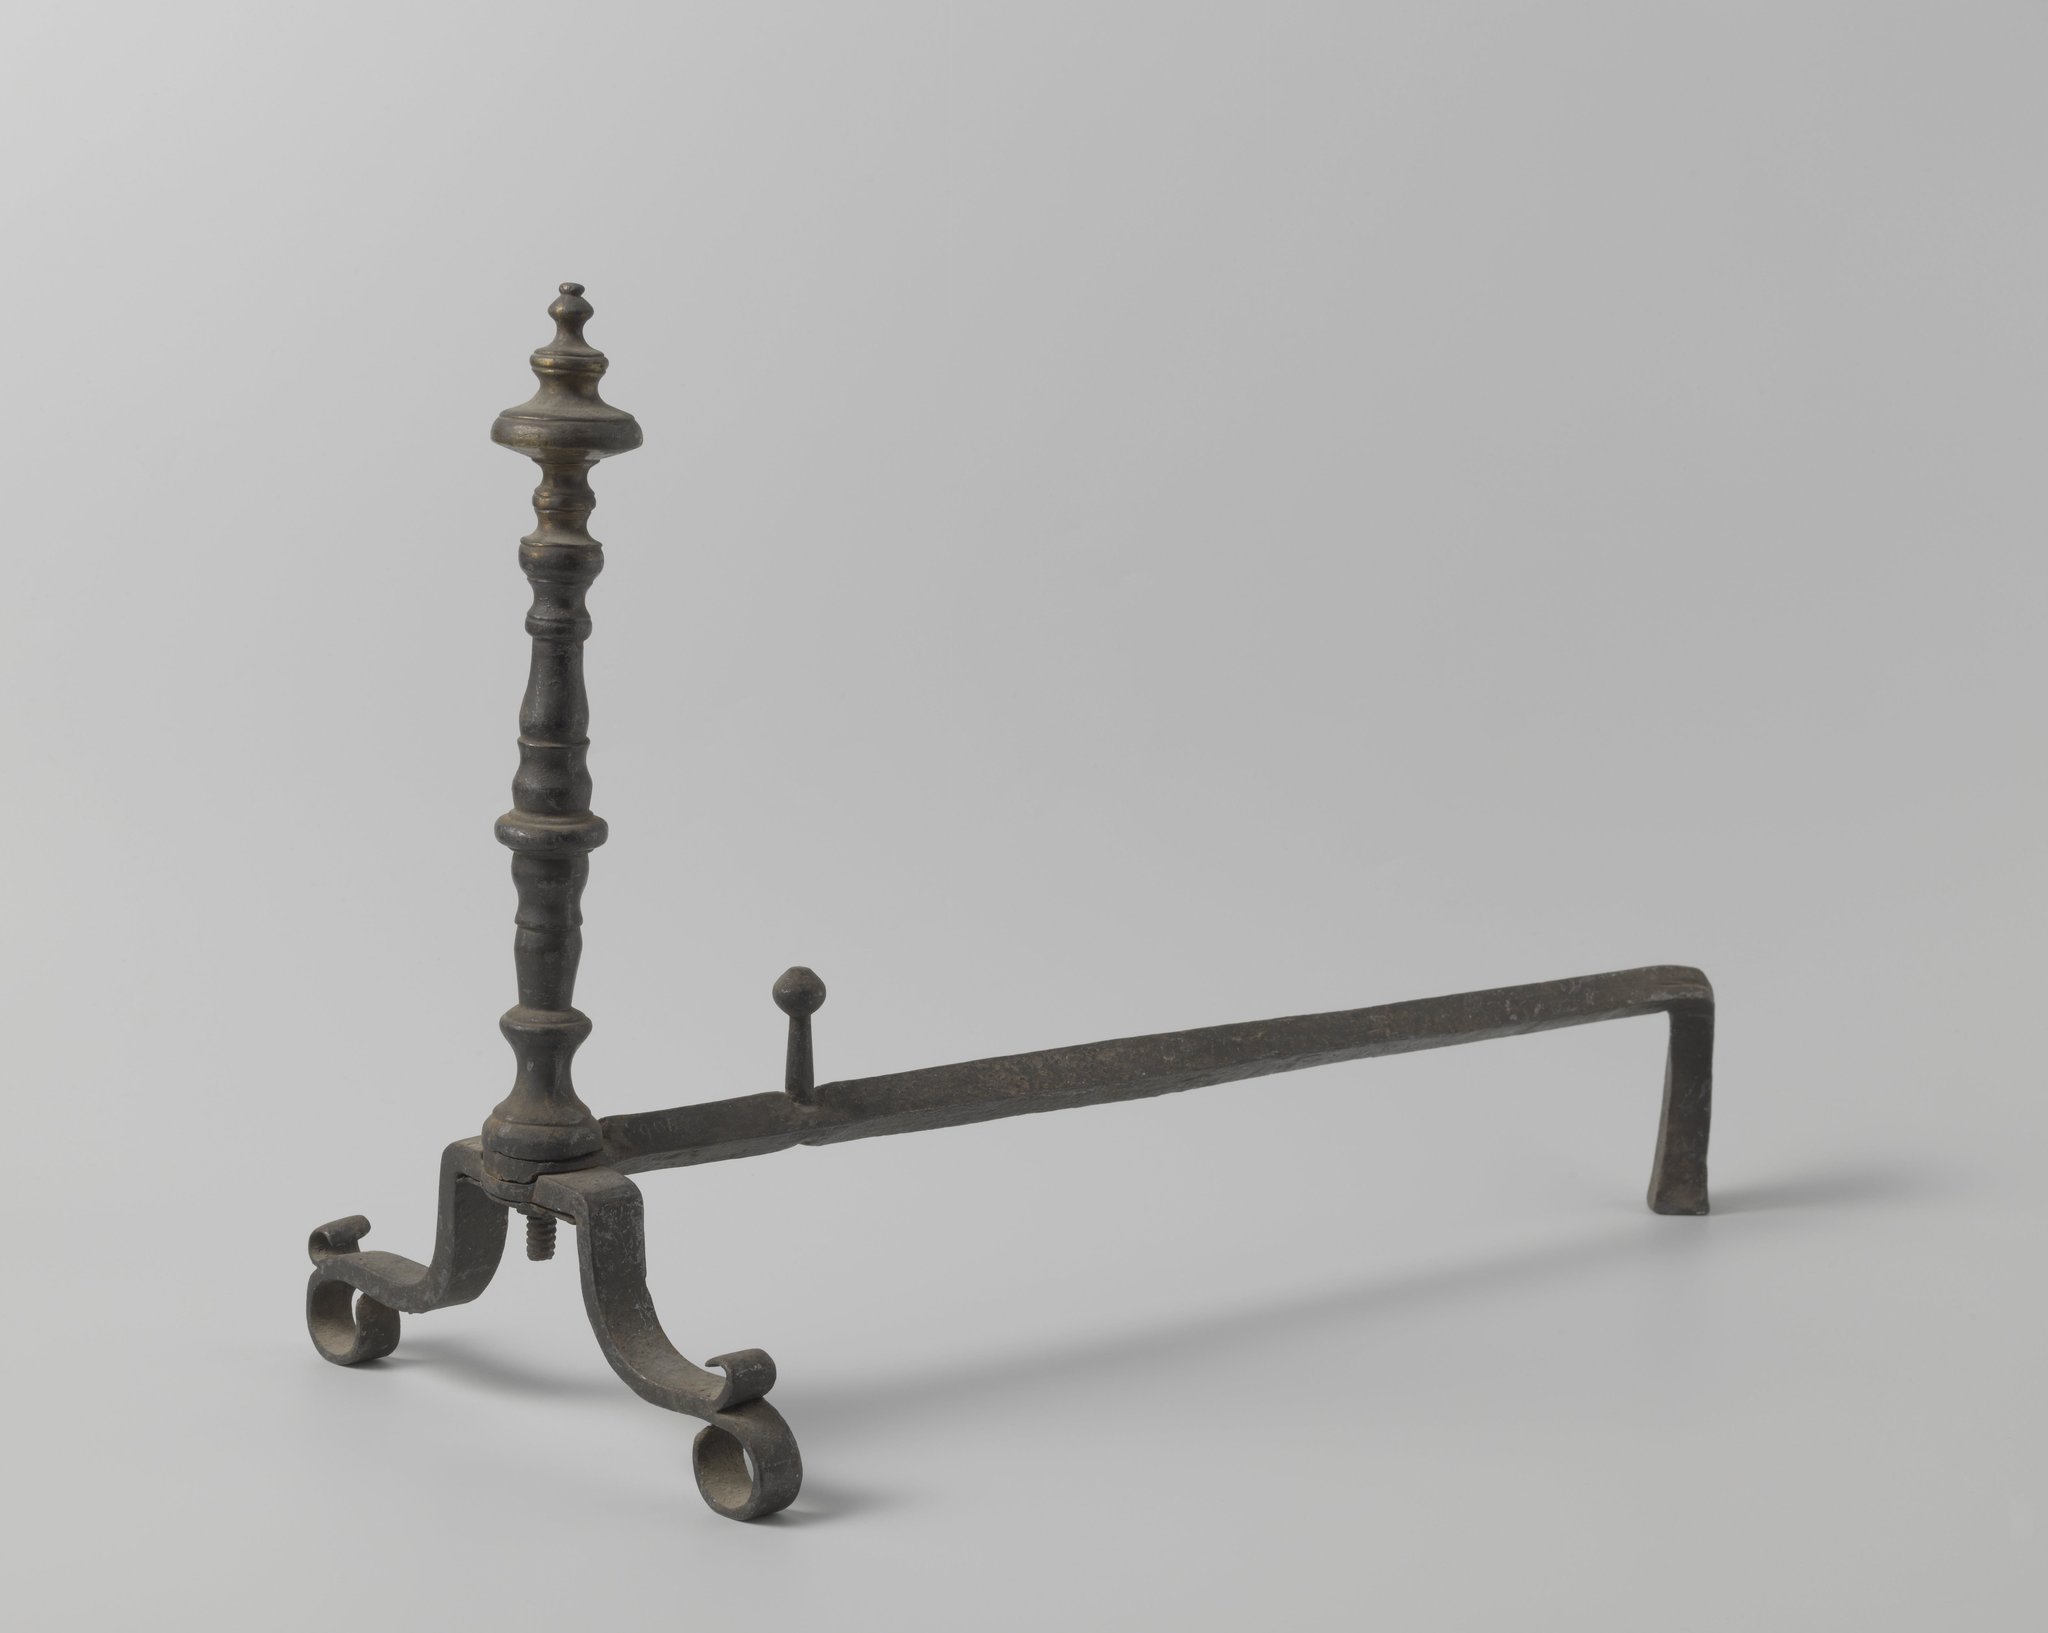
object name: vuurijzer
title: Vuurijzer met een koperen knop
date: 1400-1950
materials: copper, iron